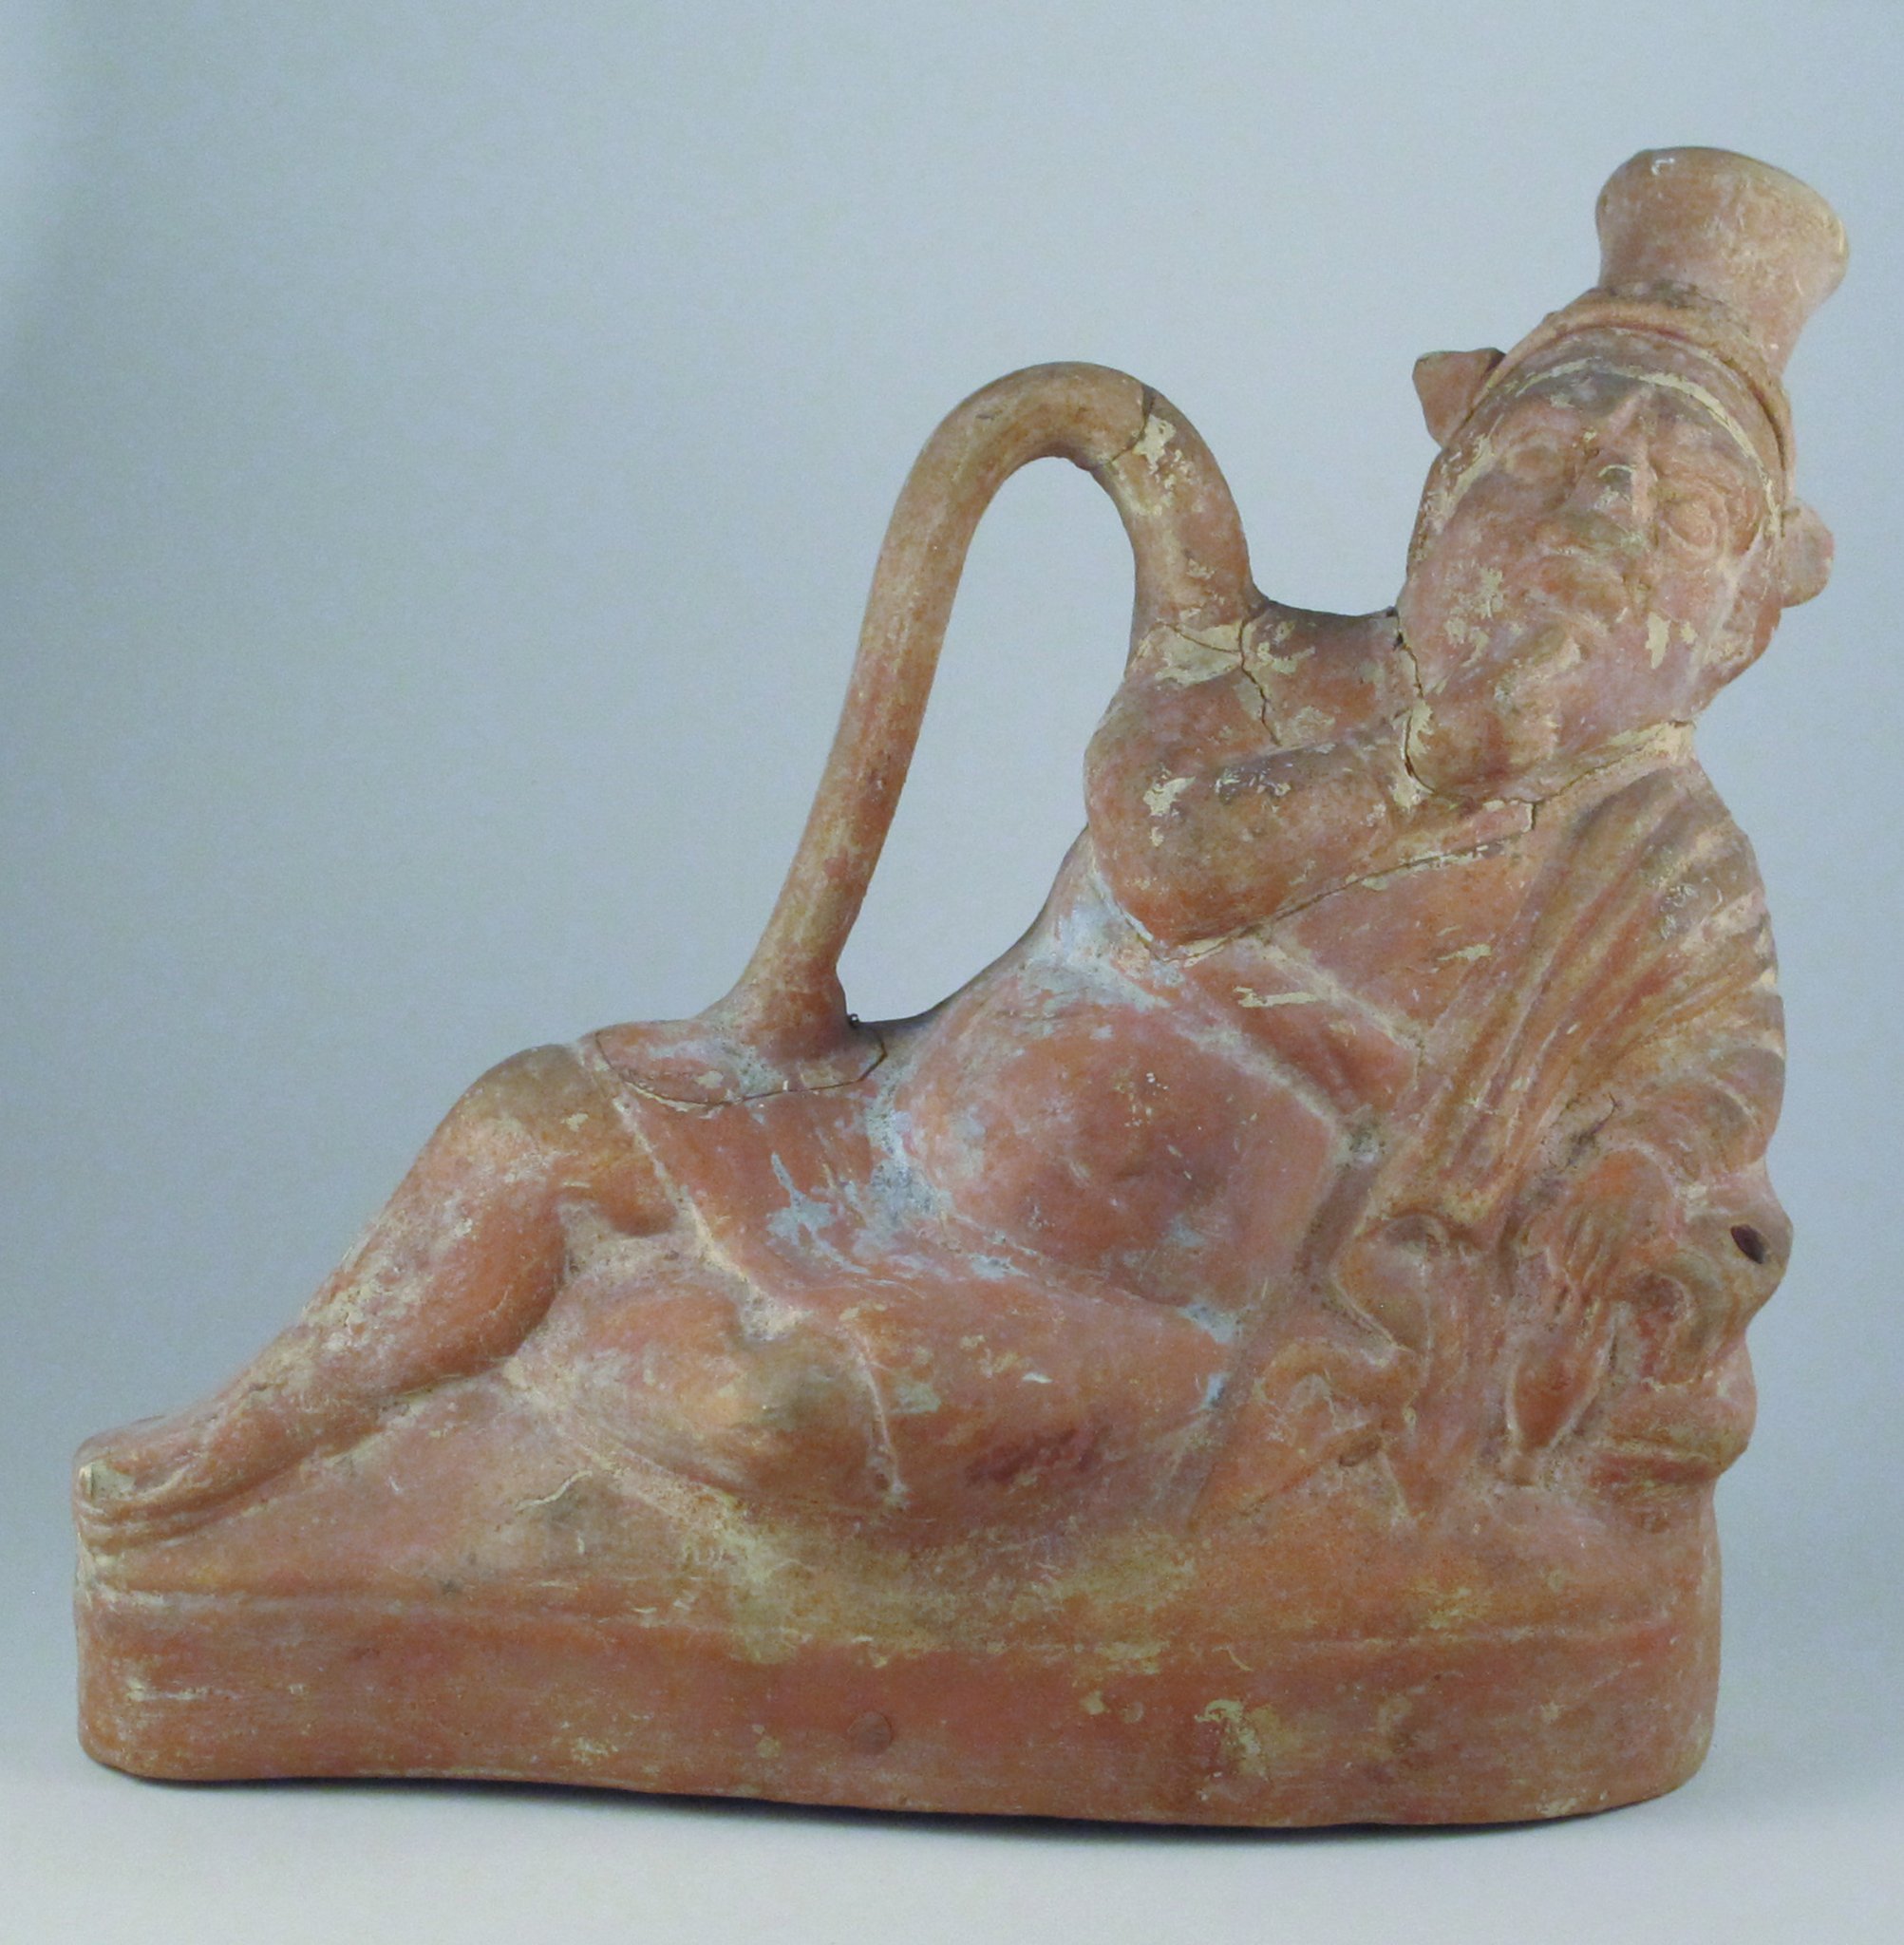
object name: bottle in the form of a man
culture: roman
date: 670 BCE-330 CE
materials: terracotta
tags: men